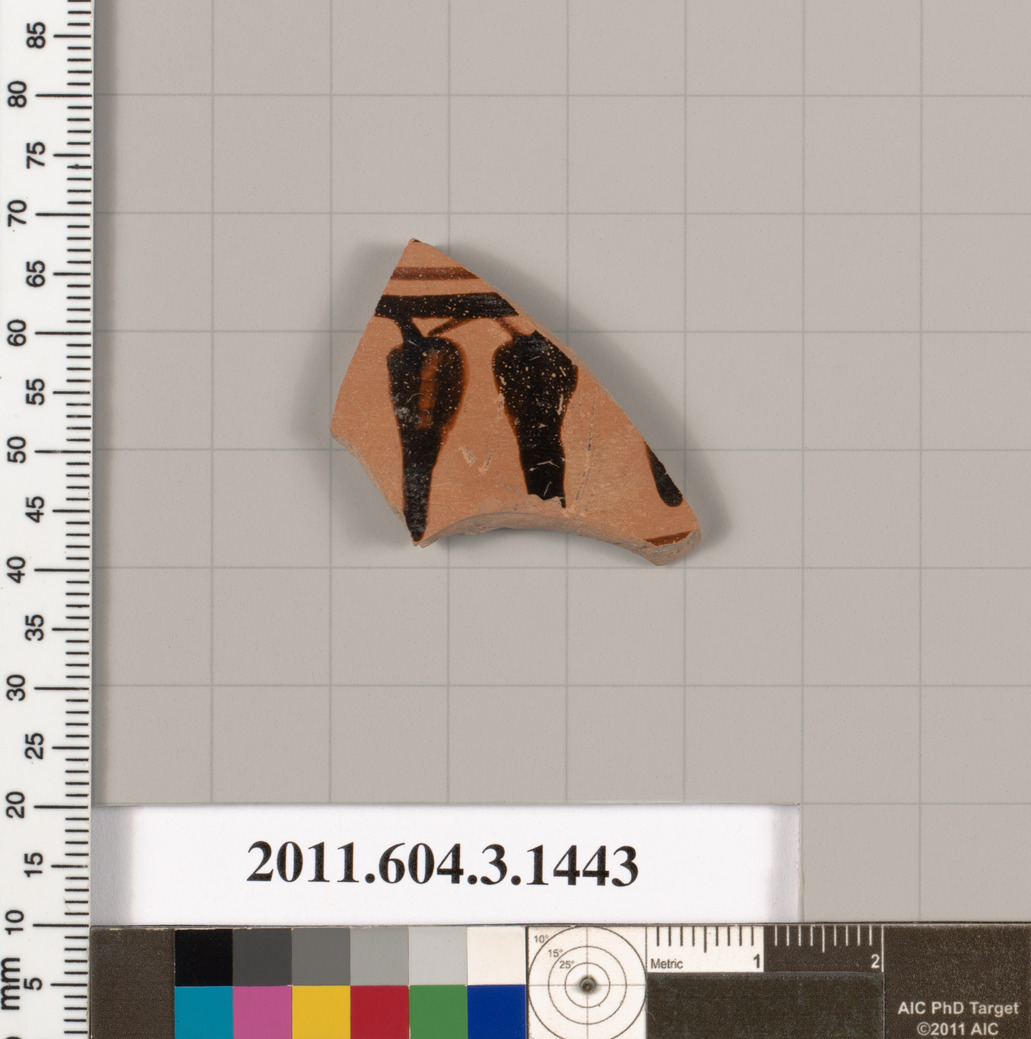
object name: skyphos fragment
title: Terracotta fragment of a skyphos (deep drinking cup)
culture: greek, attic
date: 534-501 BCE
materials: terracotta